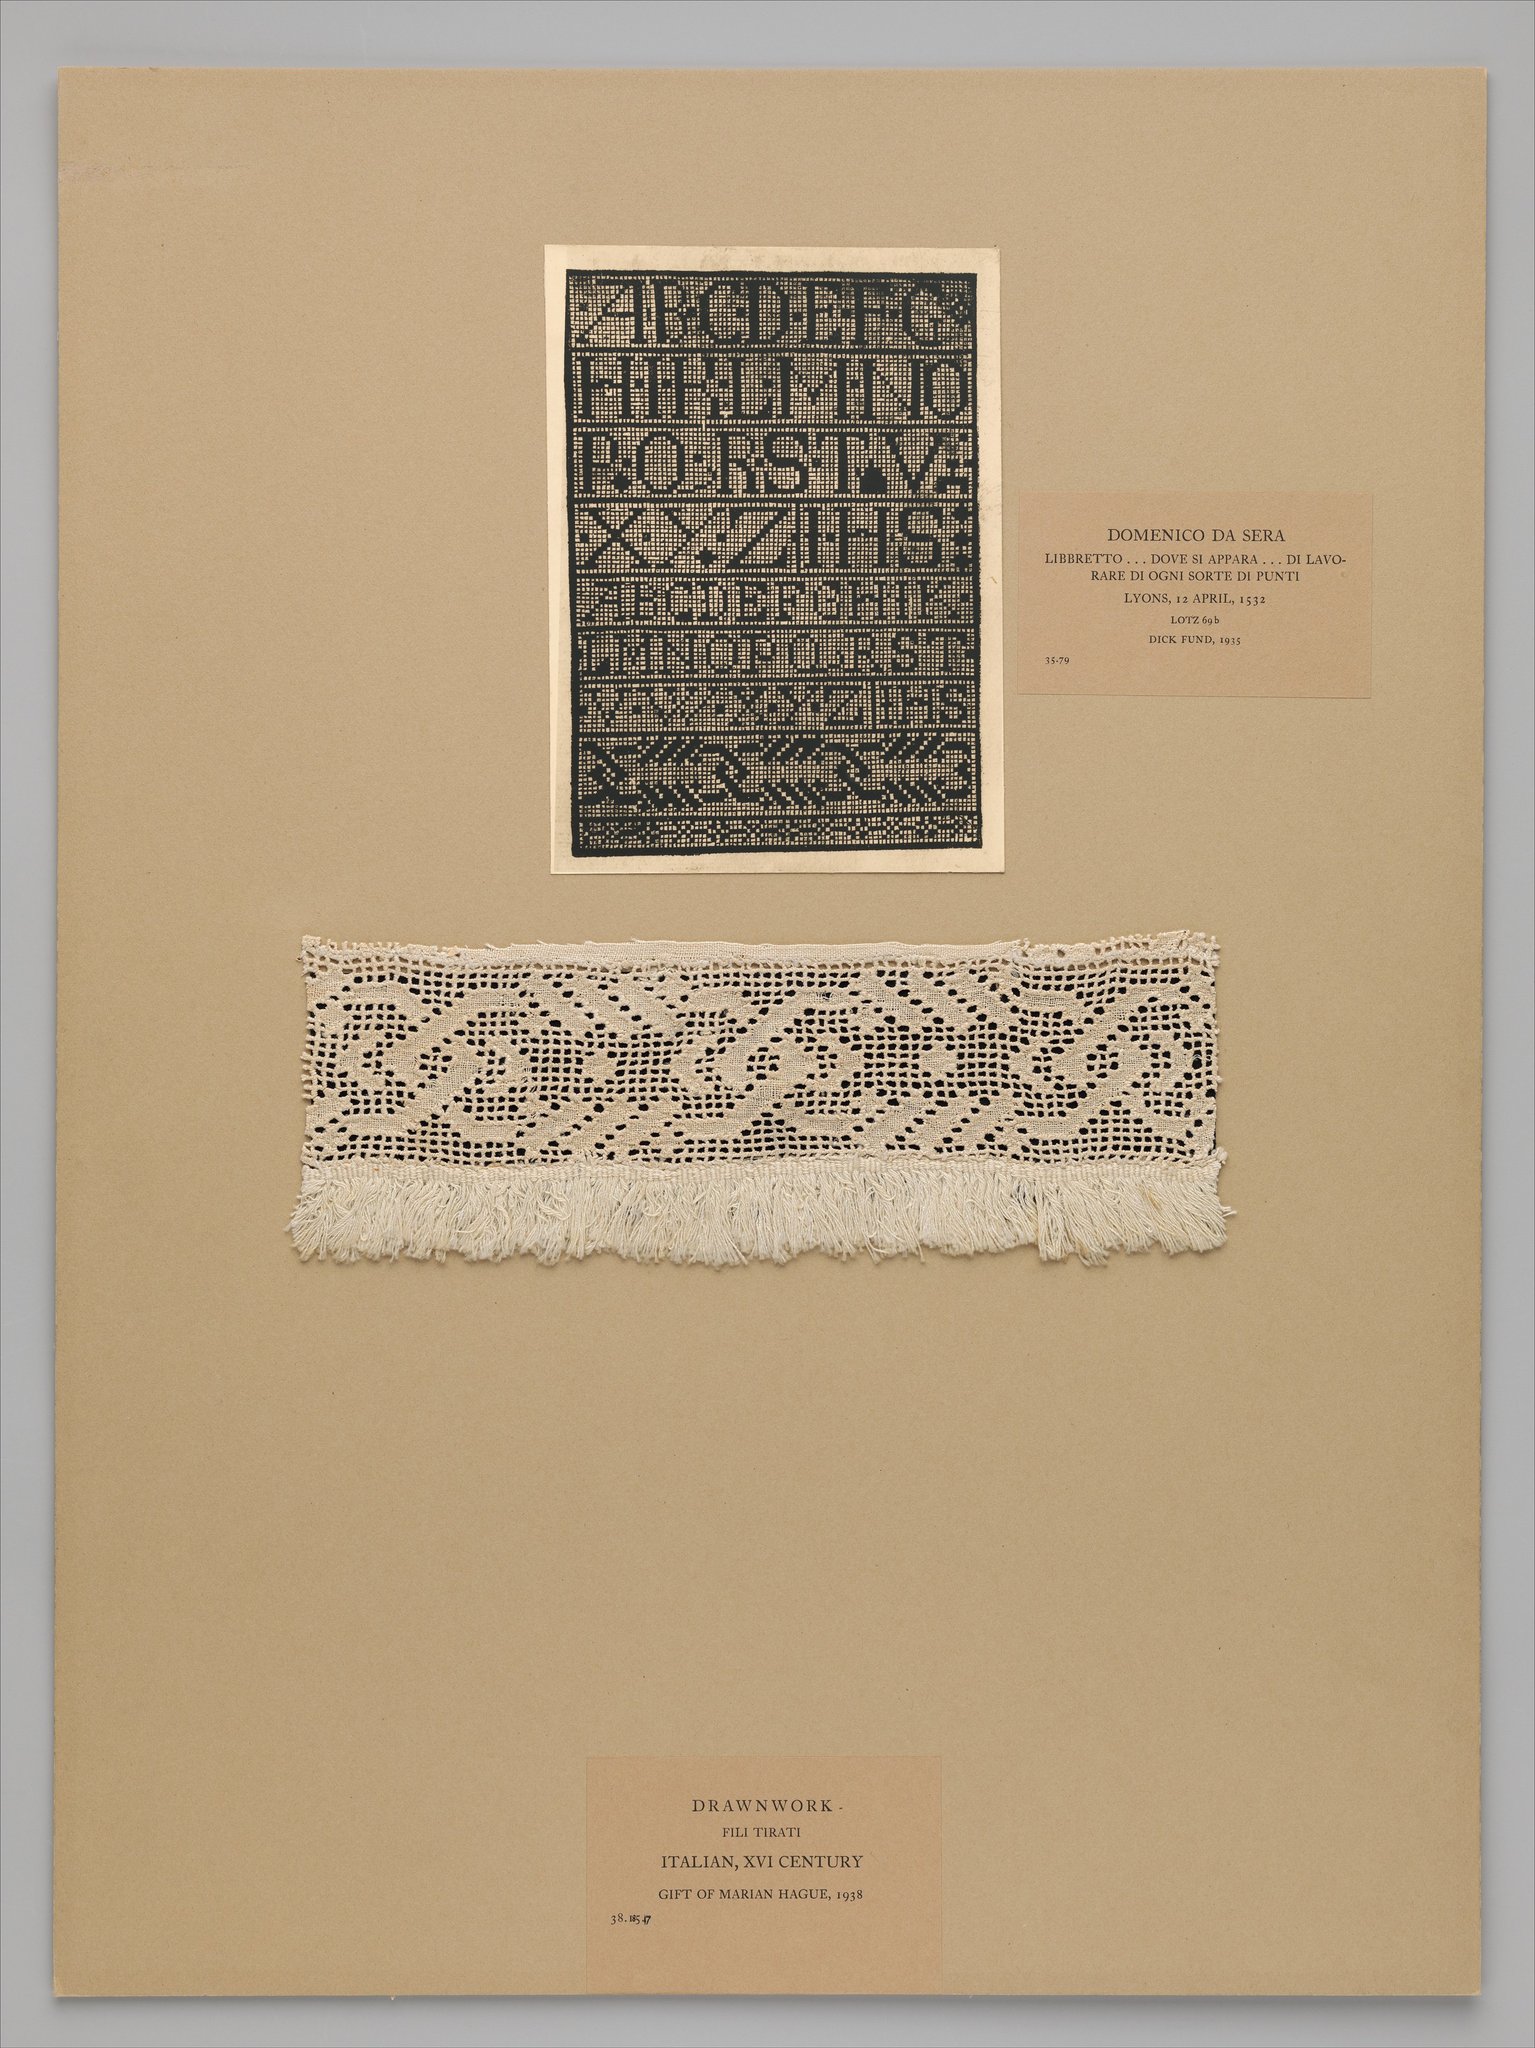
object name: insertion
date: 1501-1600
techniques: embroidery